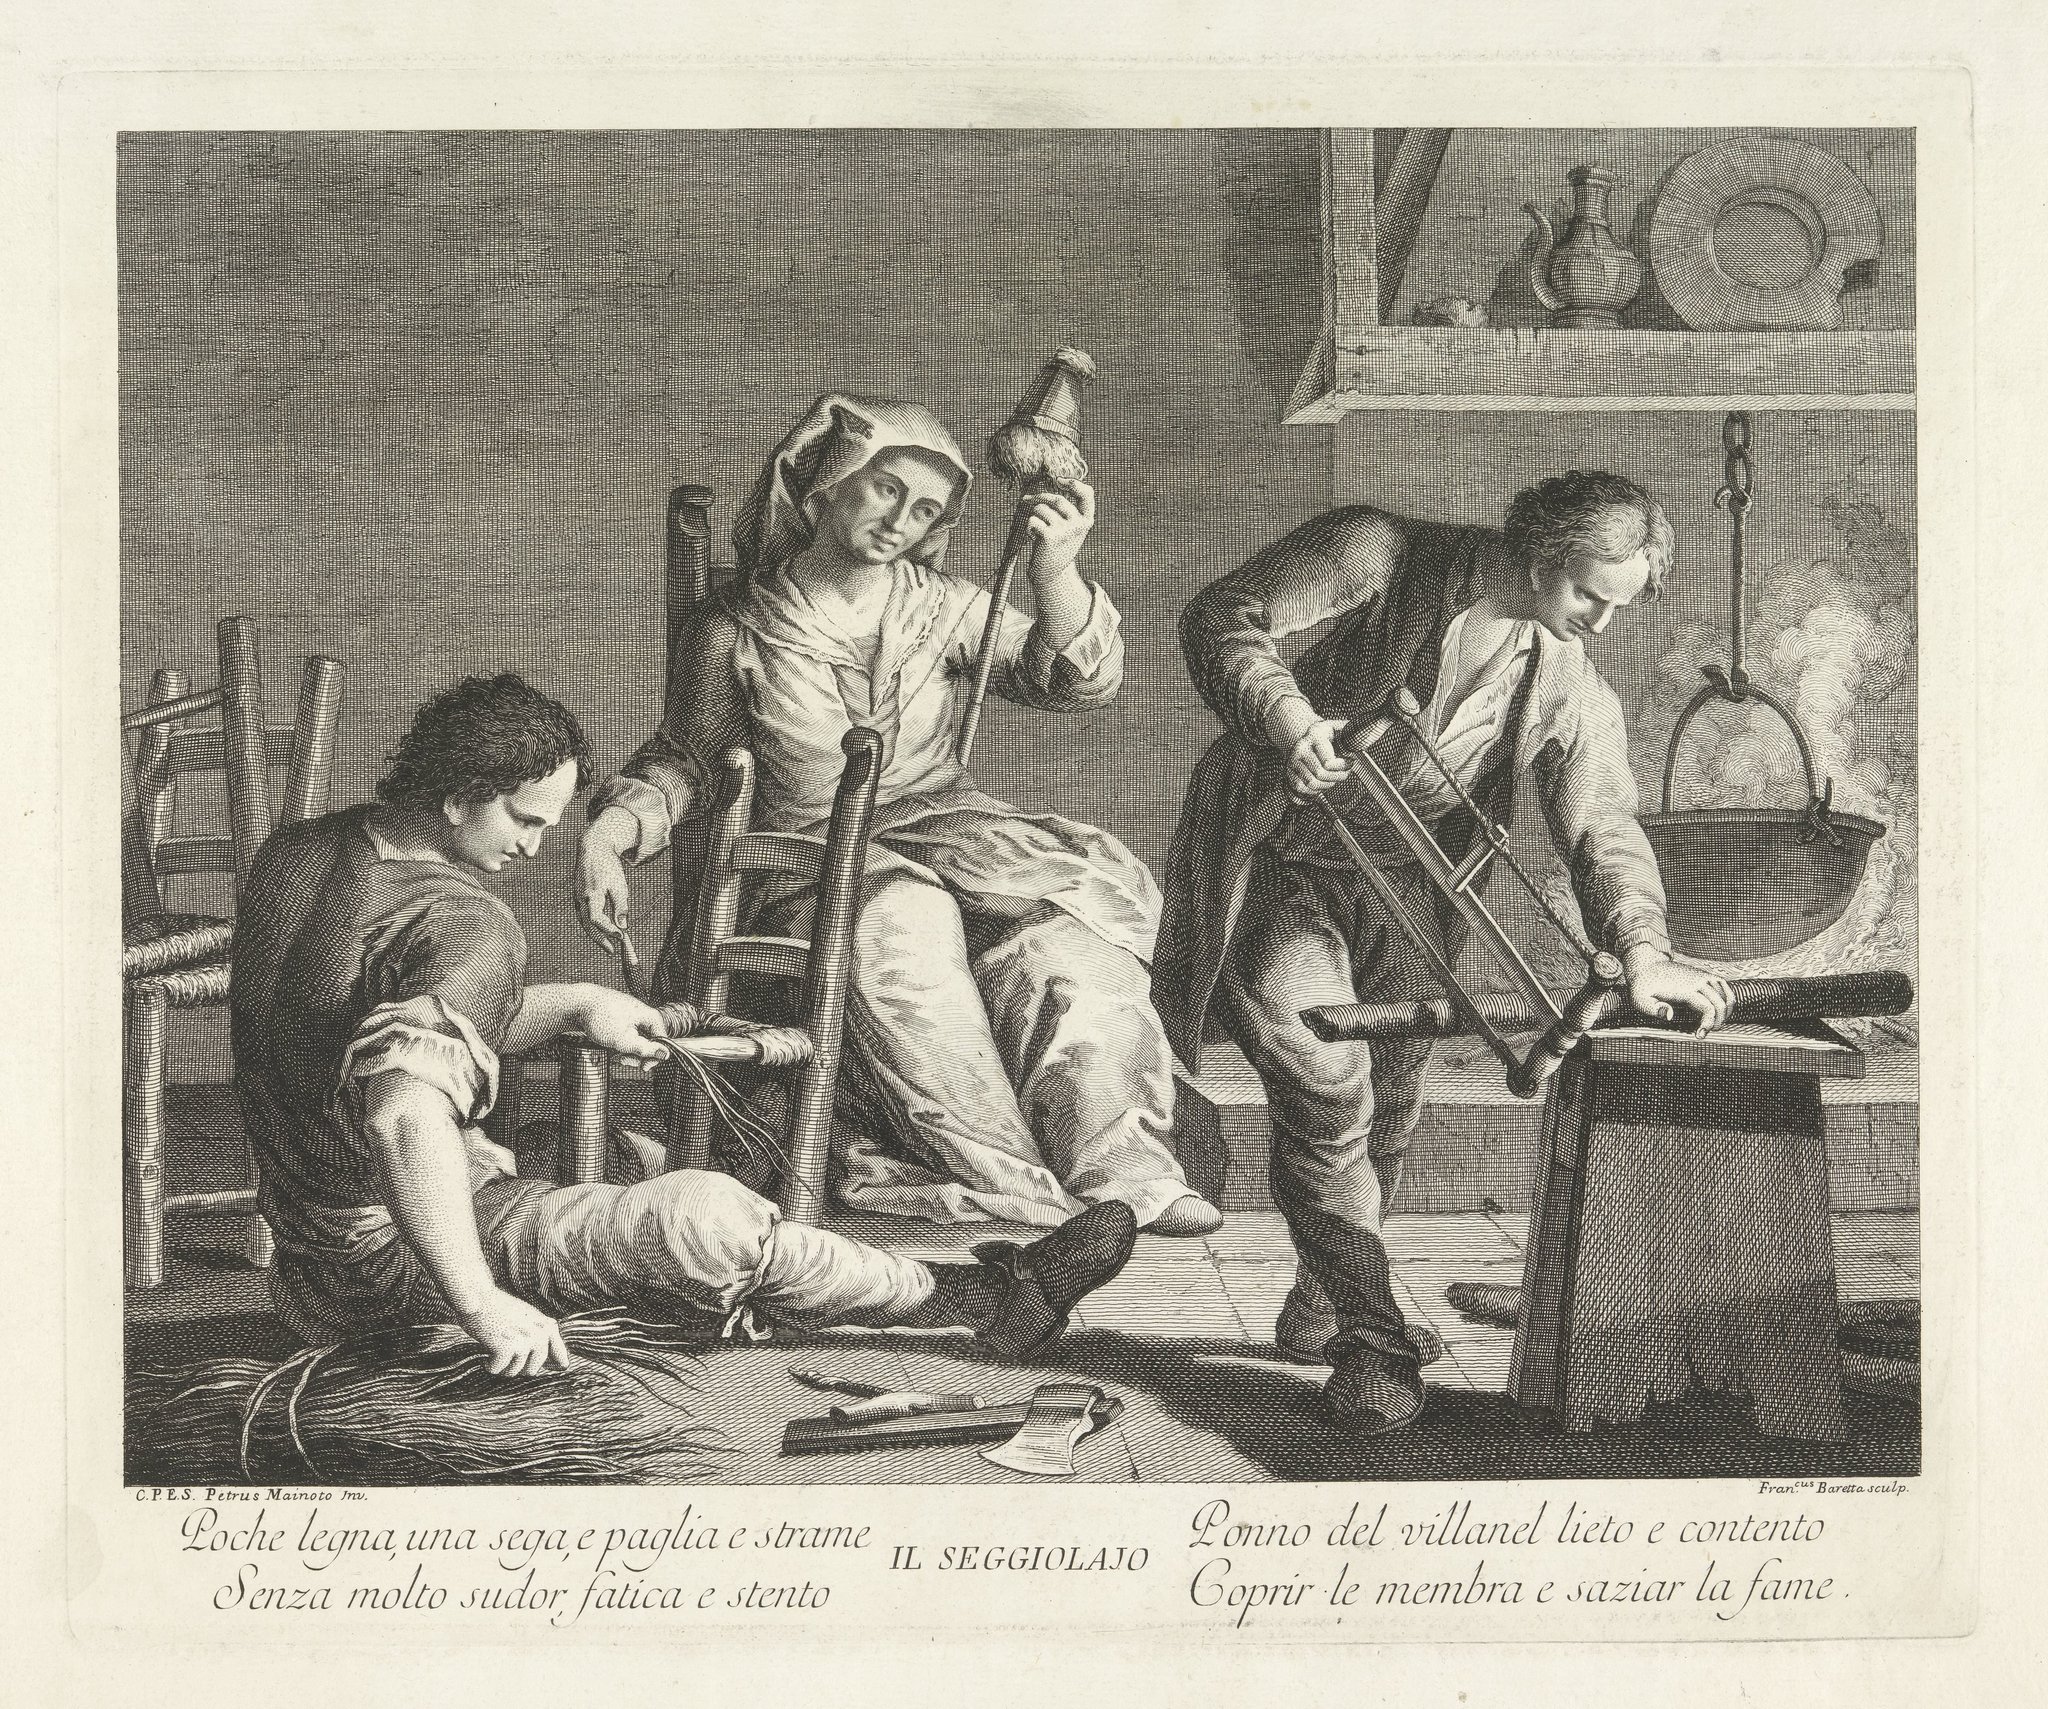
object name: print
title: Poche legna, una sega, e paglia e strame / Senza molto sudor fatica e stento (...)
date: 1700-1850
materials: paper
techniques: engraving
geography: italy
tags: craft-production, skilled handiwork, stool, crafts and industries, spinning (manufacture of yarn), sawing (industrial process)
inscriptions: collector's mark: Lugt 240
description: Zicht in een keuken met een stoelenmaker, een spinster en een zagende man. Rechts staat een ketel op het vuur. In de ondermarge de titel.